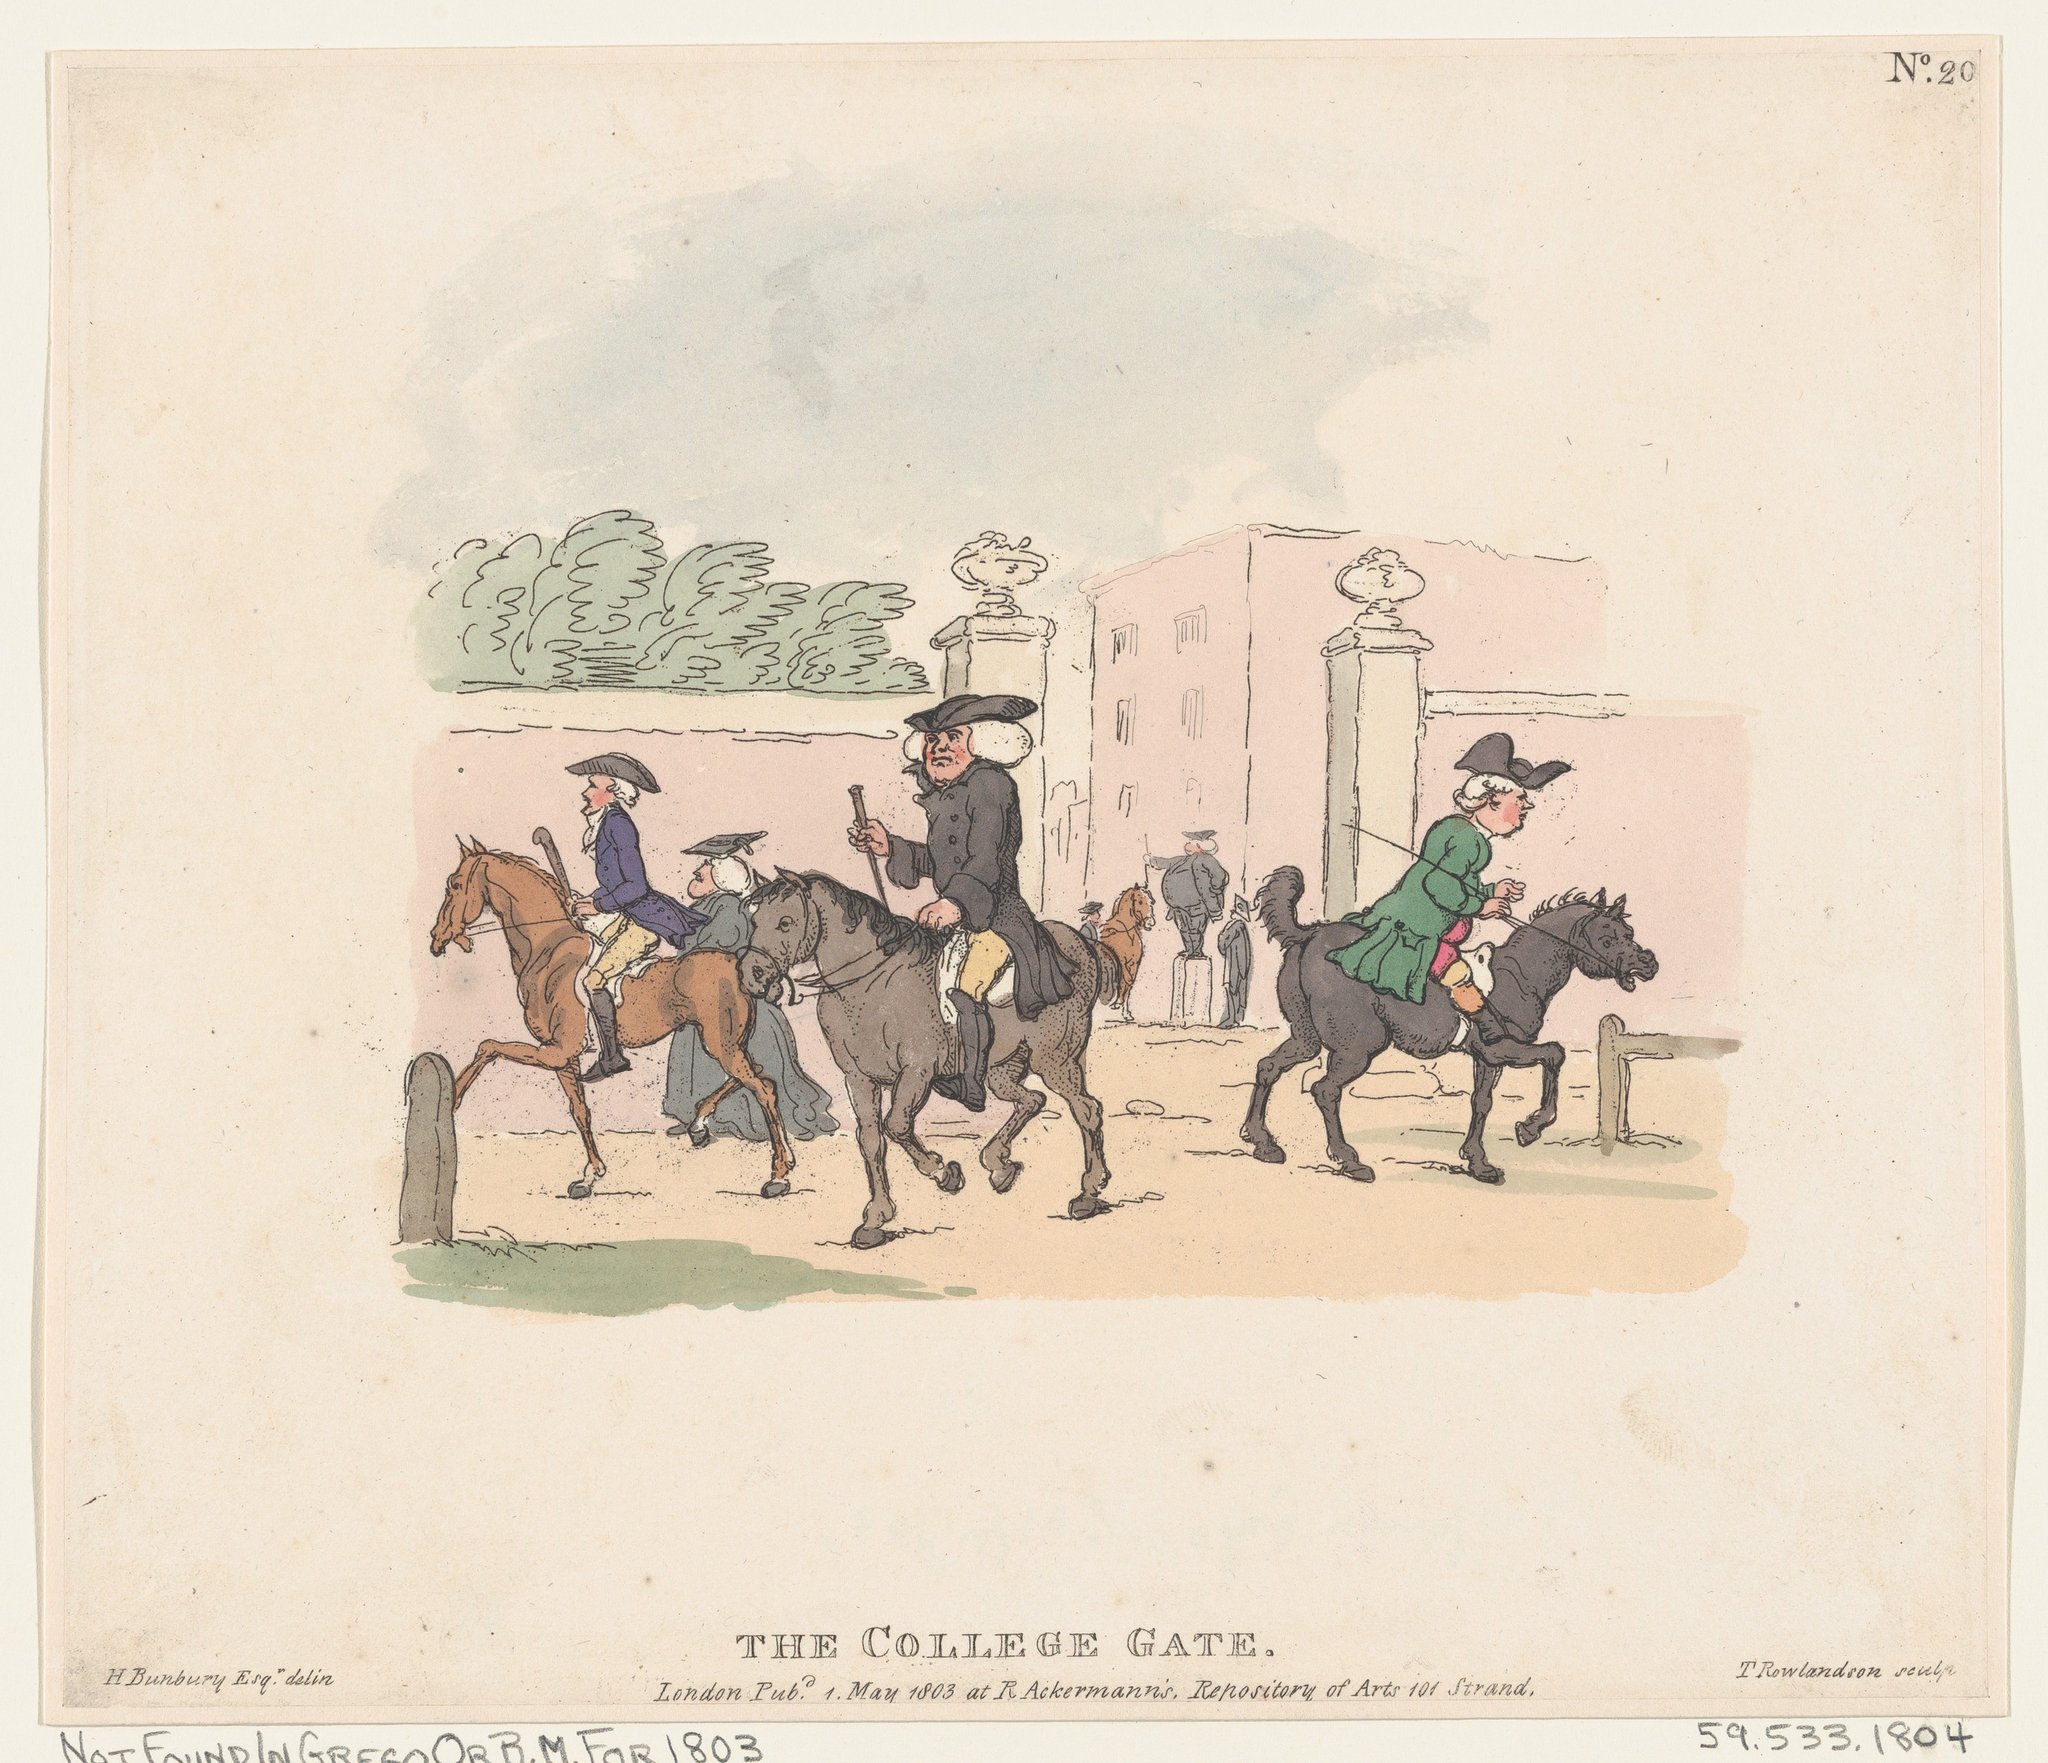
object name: print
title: The College Gate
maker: thomas rowlandson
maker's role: artist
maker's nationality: british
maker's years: 1757-1827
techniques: etching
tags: men,horses